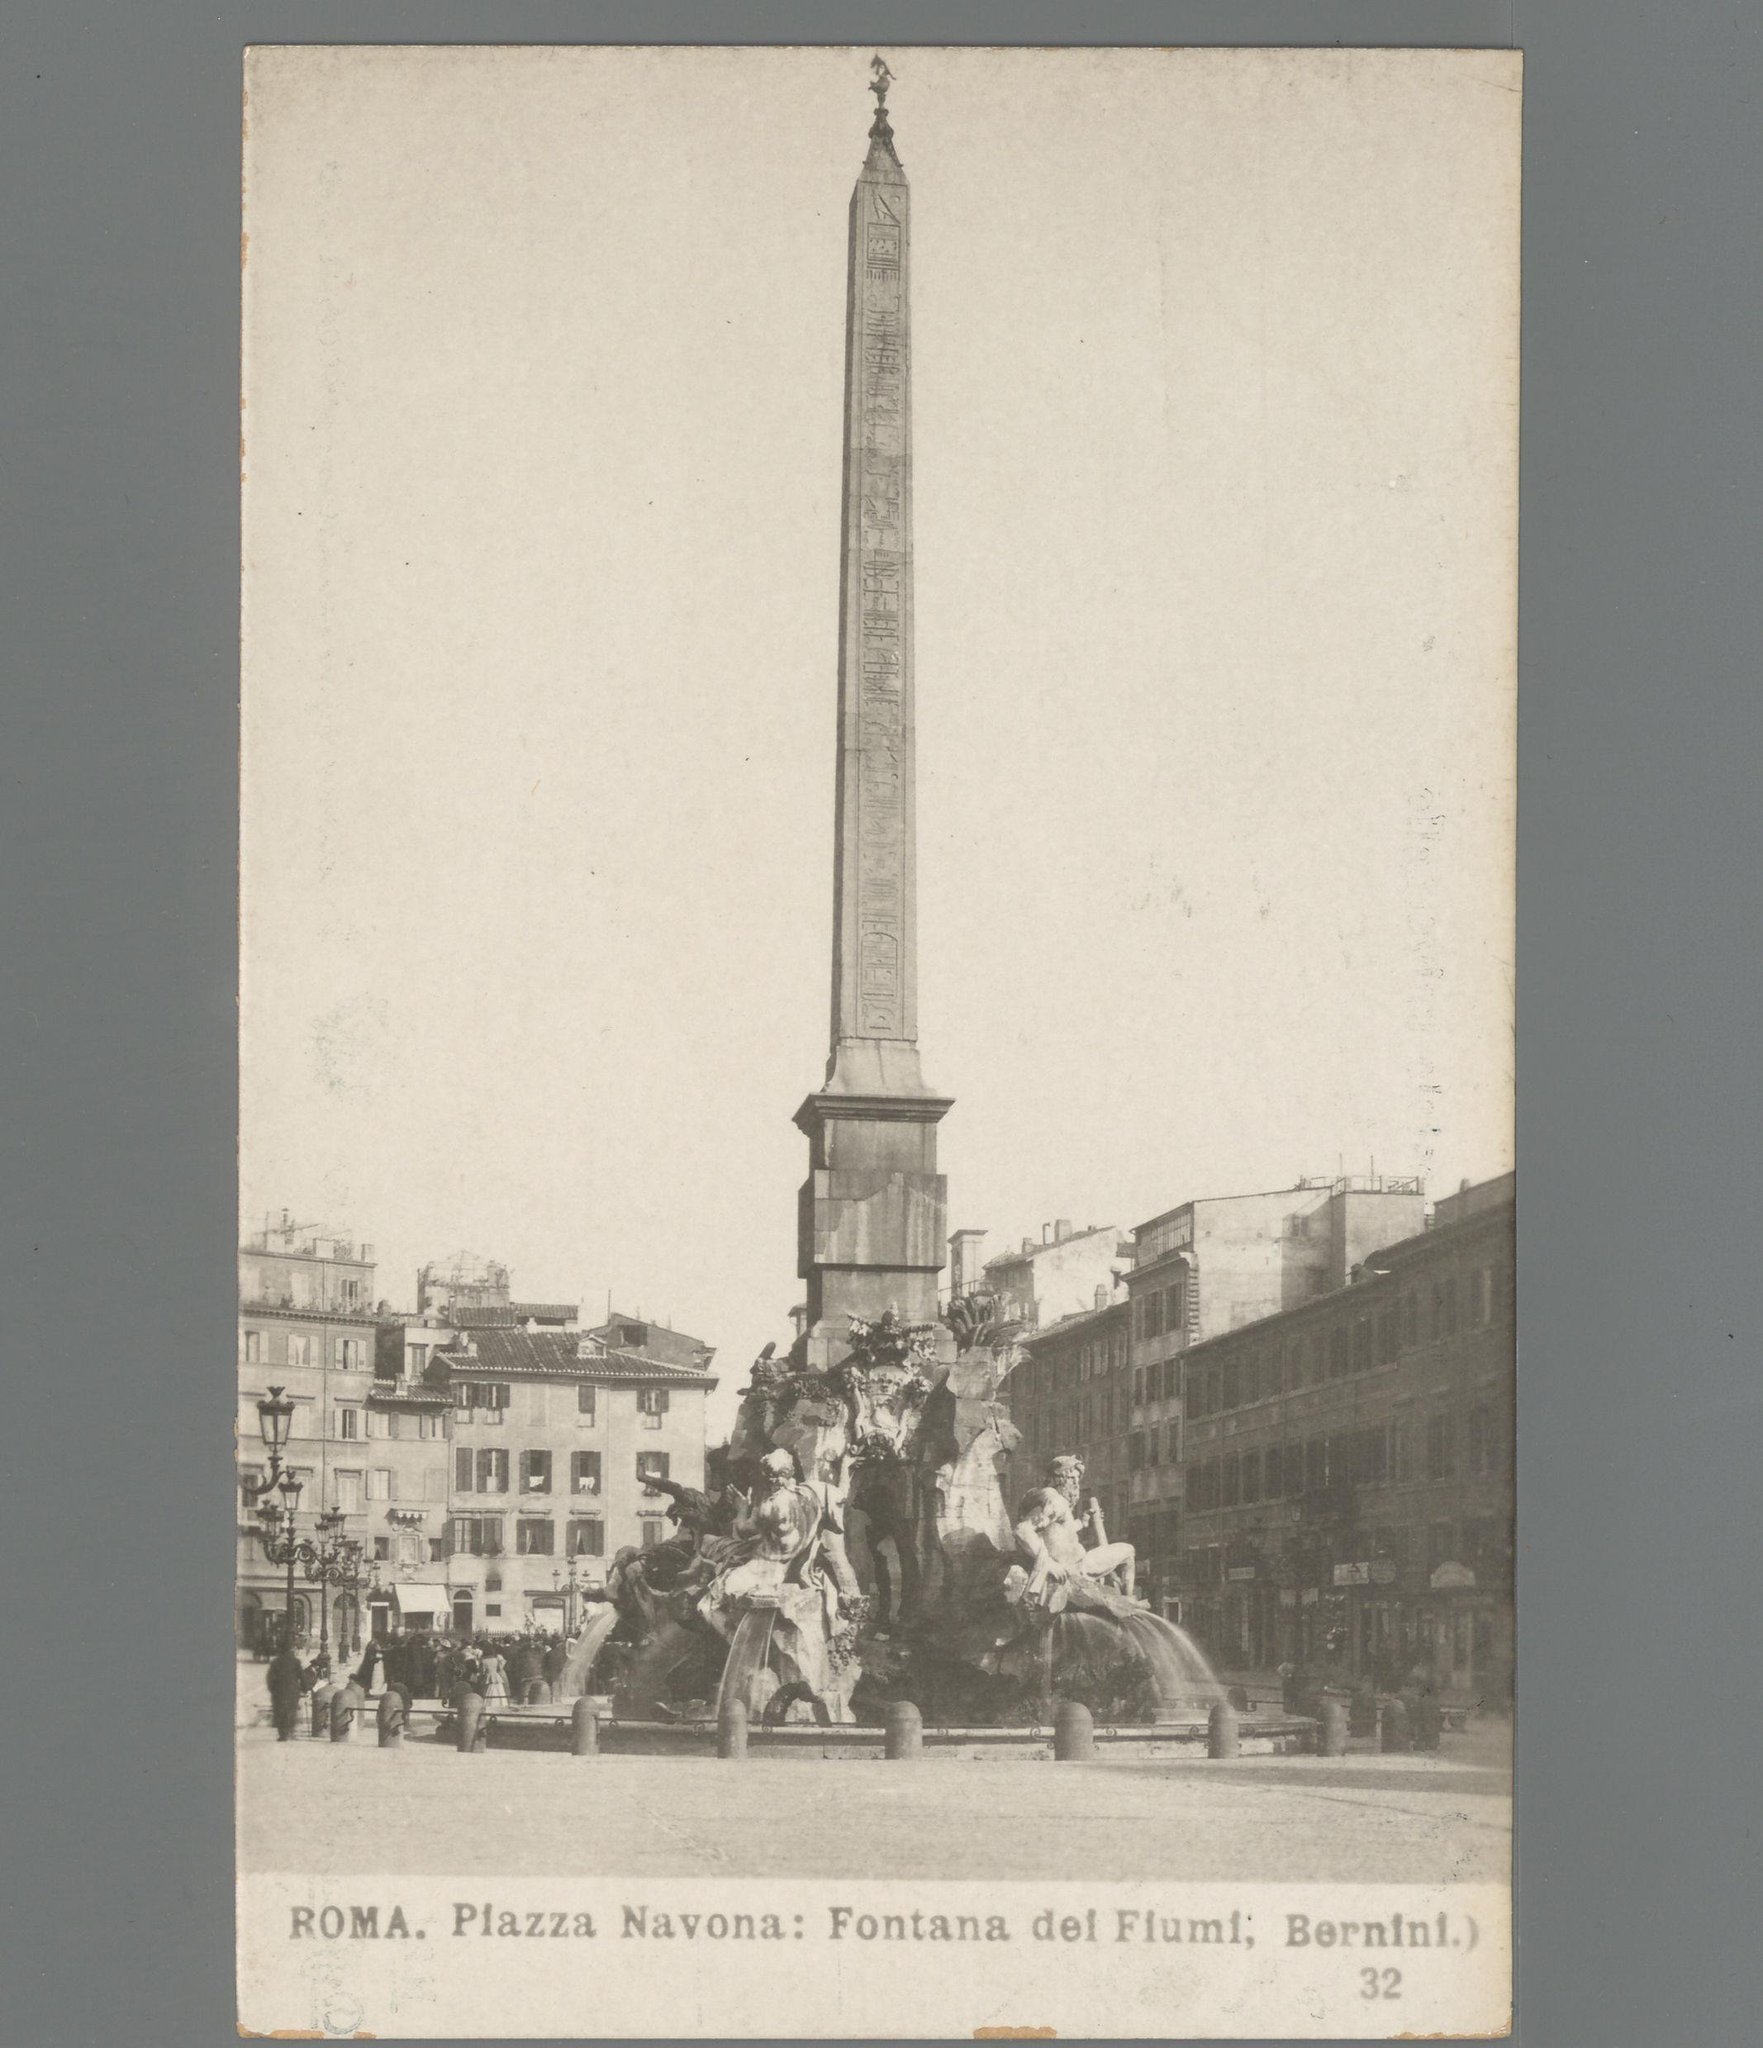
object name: ansichtkaart, prentbriefkaart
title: Roma. Piazza Navona. Fontana dei Fiumi (Bernini)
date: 1900-1906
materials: photographic support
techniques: photography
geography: italy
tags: square, place, circus, etc. (+ city(-scape) with figures, staffage), ornamental fountain (+ city(-scape) with figures, staffage)